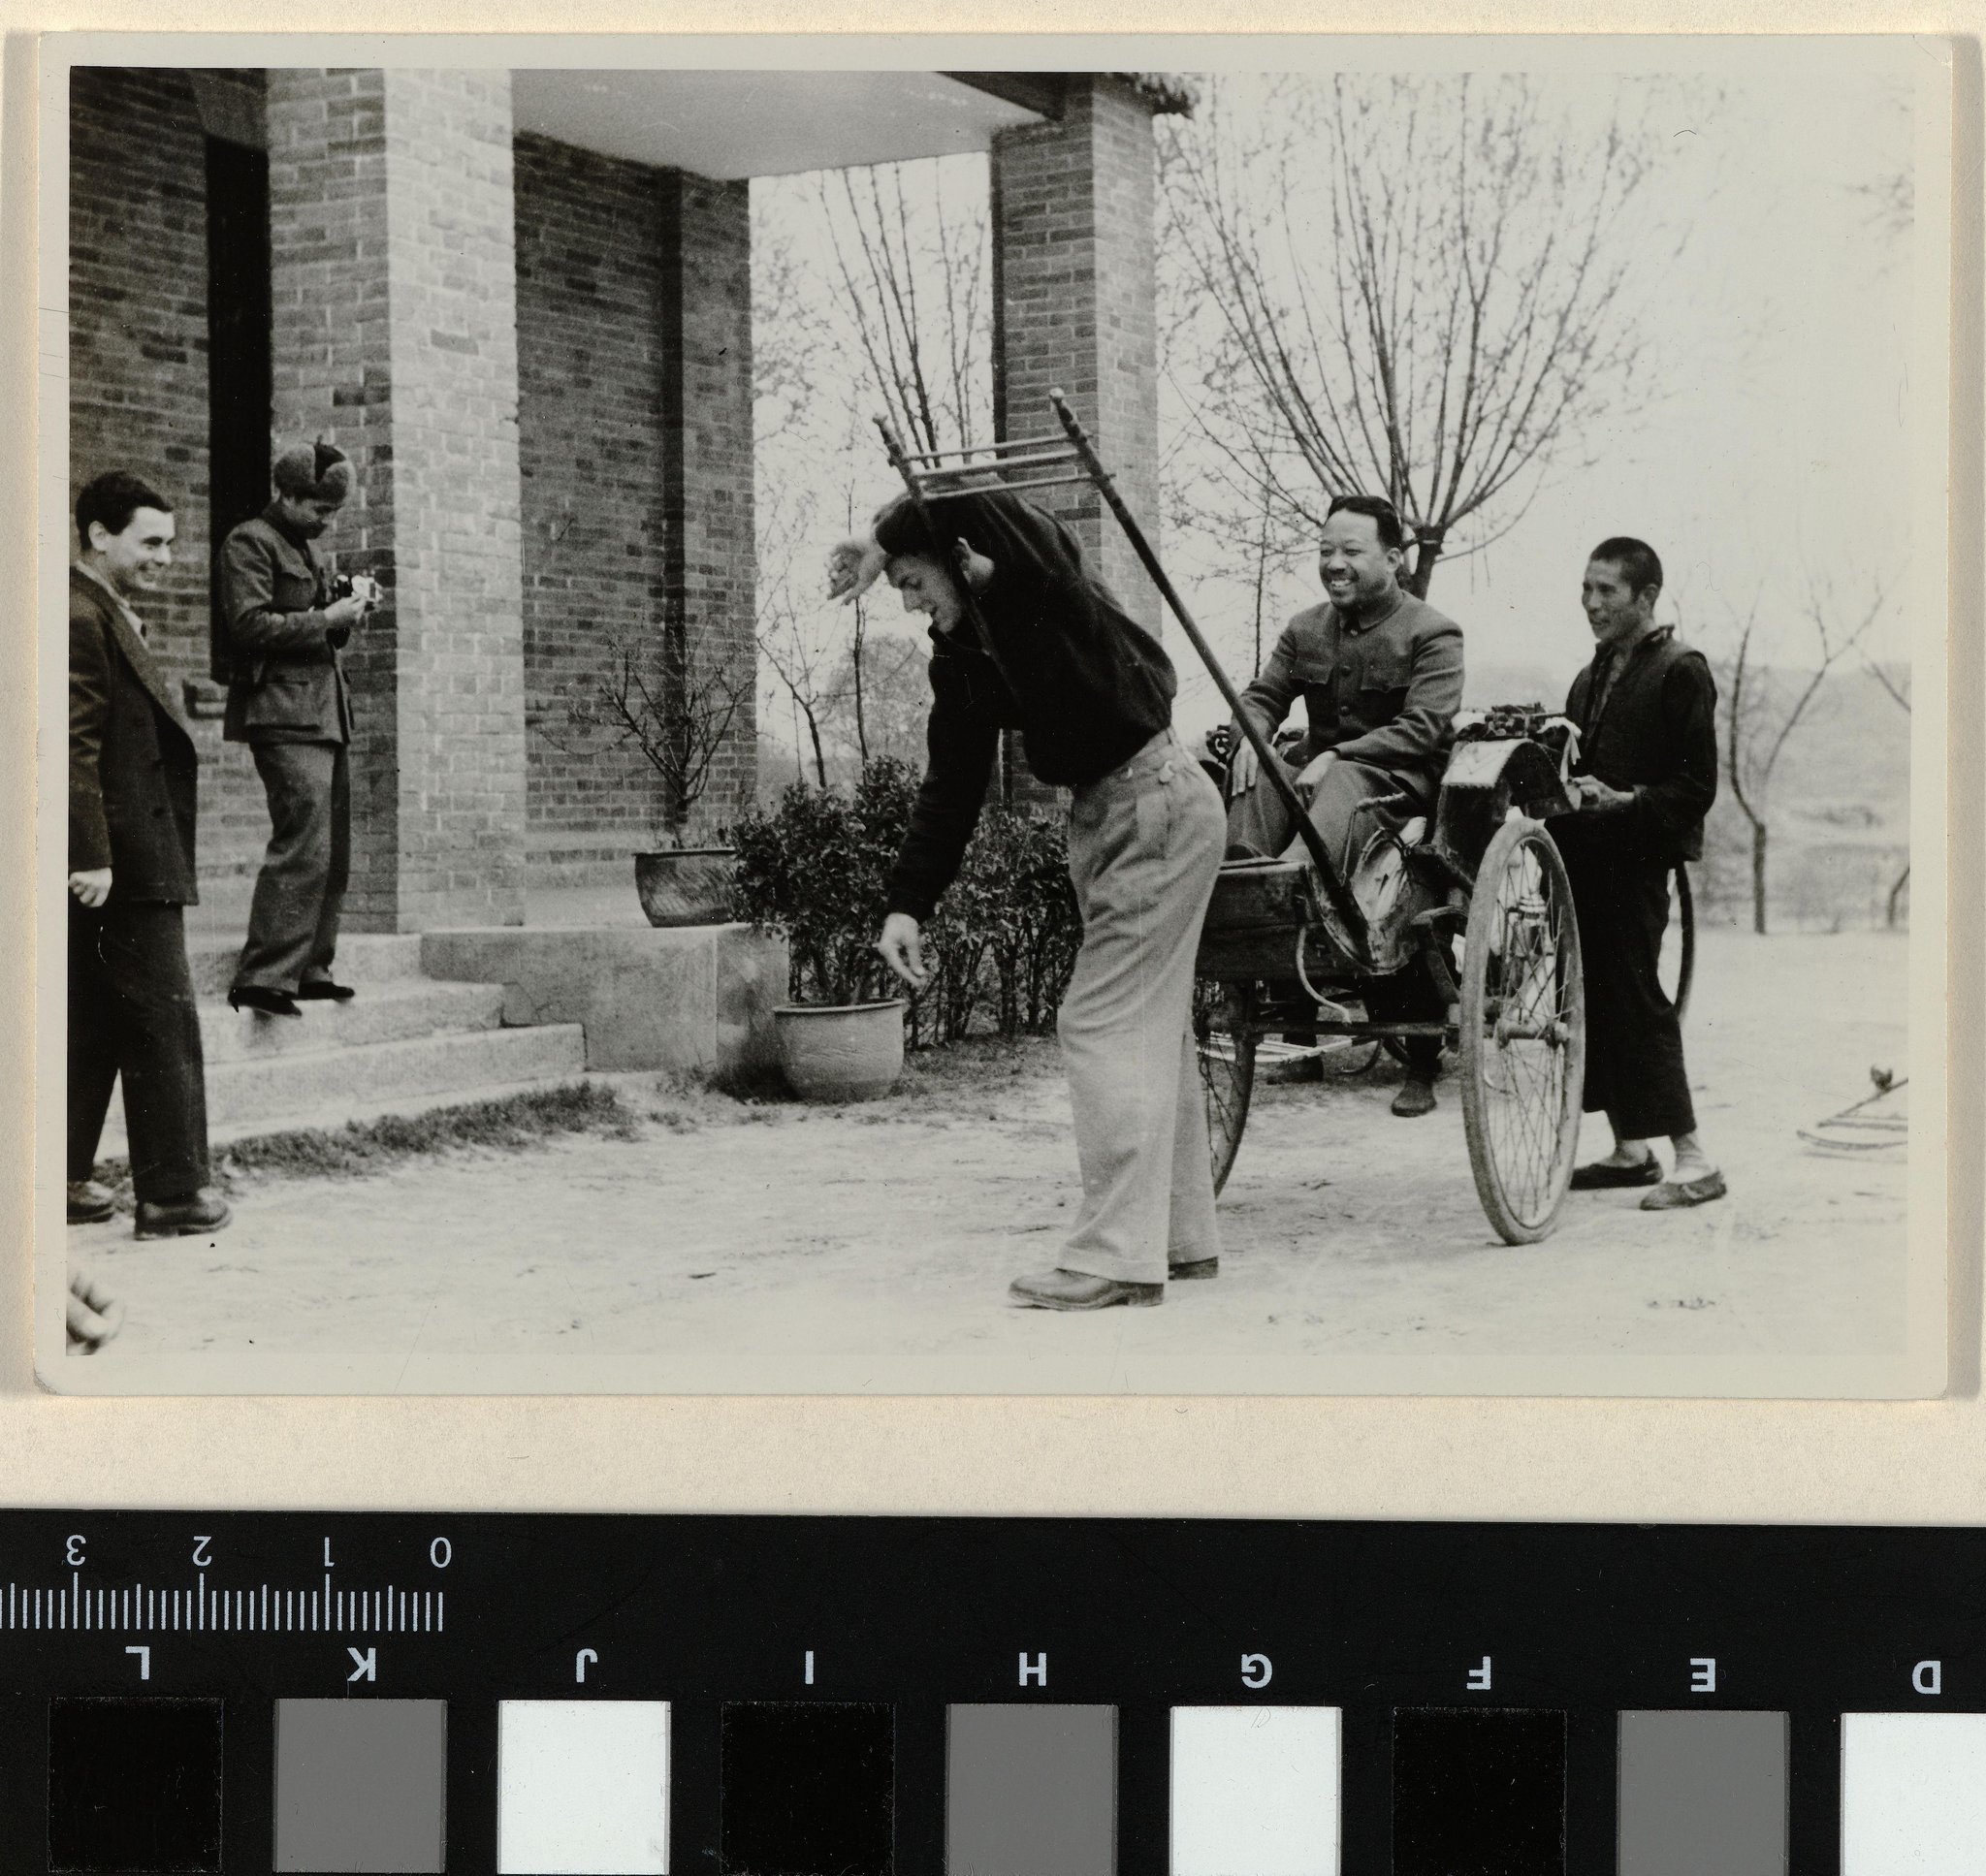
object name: photograph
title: John Fernhout als loper voor een riksja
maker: robert capa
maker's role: fotograaf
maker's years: 1913-1954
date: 1938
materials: paper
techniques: gelatin silver print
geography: china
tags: john fernhout, rickshaw, laughing, china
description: John Fernhout kruipt in de rol van trekker van een riksja. Een Chinese man zit in de kar. Andere omstanders lachen en een is bezig met een fotocamera.